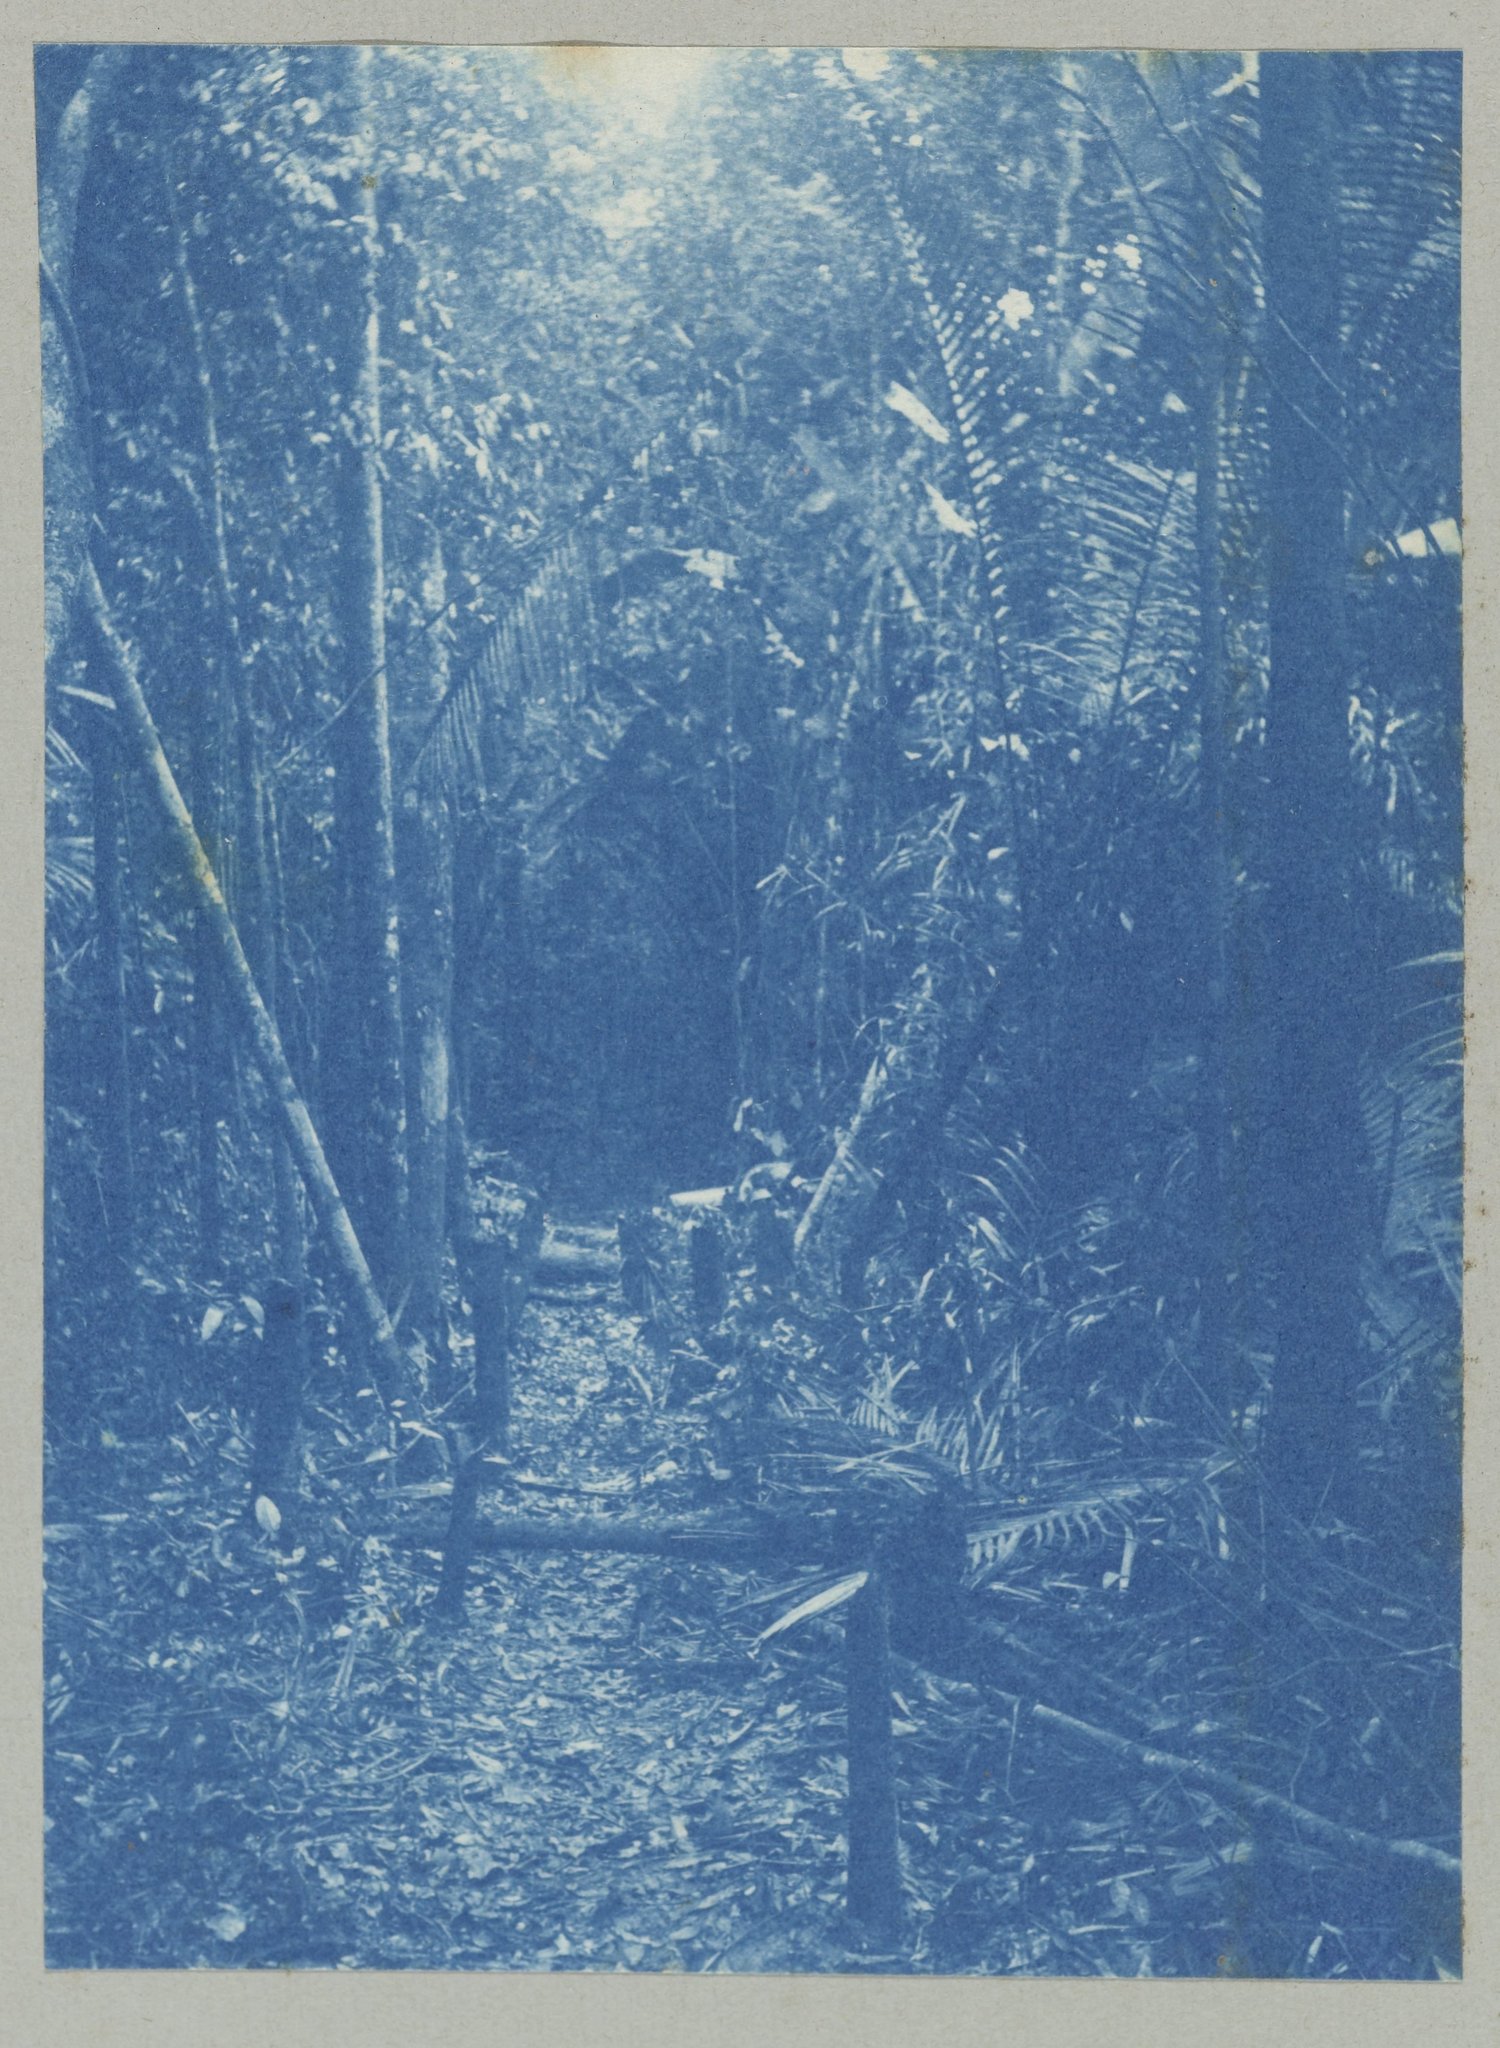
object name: photograph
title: Meetlijn bij de Witwatra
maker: hendrik doijer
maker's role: engineer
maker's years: 1863-1925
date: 1903-1910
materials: photographic support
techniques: cyanotype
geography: suriname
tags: suriname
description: Meetlijn in het oerwoud. Onderdeel van het fotoalbum Souvenir de Voyage (deel 1), over het leven van de familie Doijer in en rond de plantage Ma Retraite in Suriname in de jaren 1903-1910.